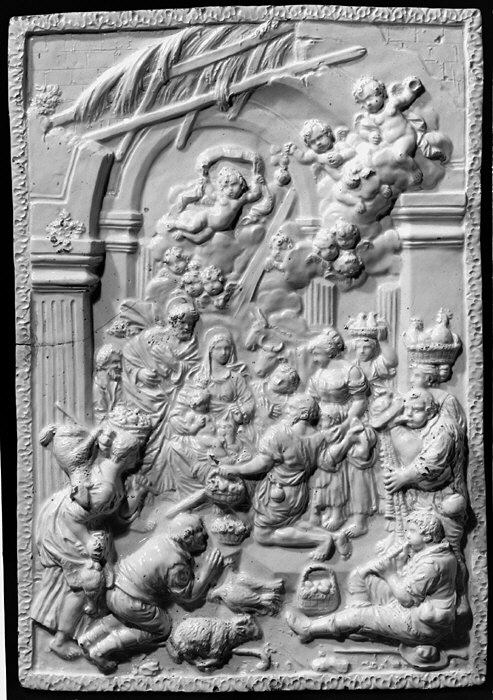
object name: plaque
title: Adoration of the Shepherds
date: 1780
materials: creamware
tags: adoration of the shepherds